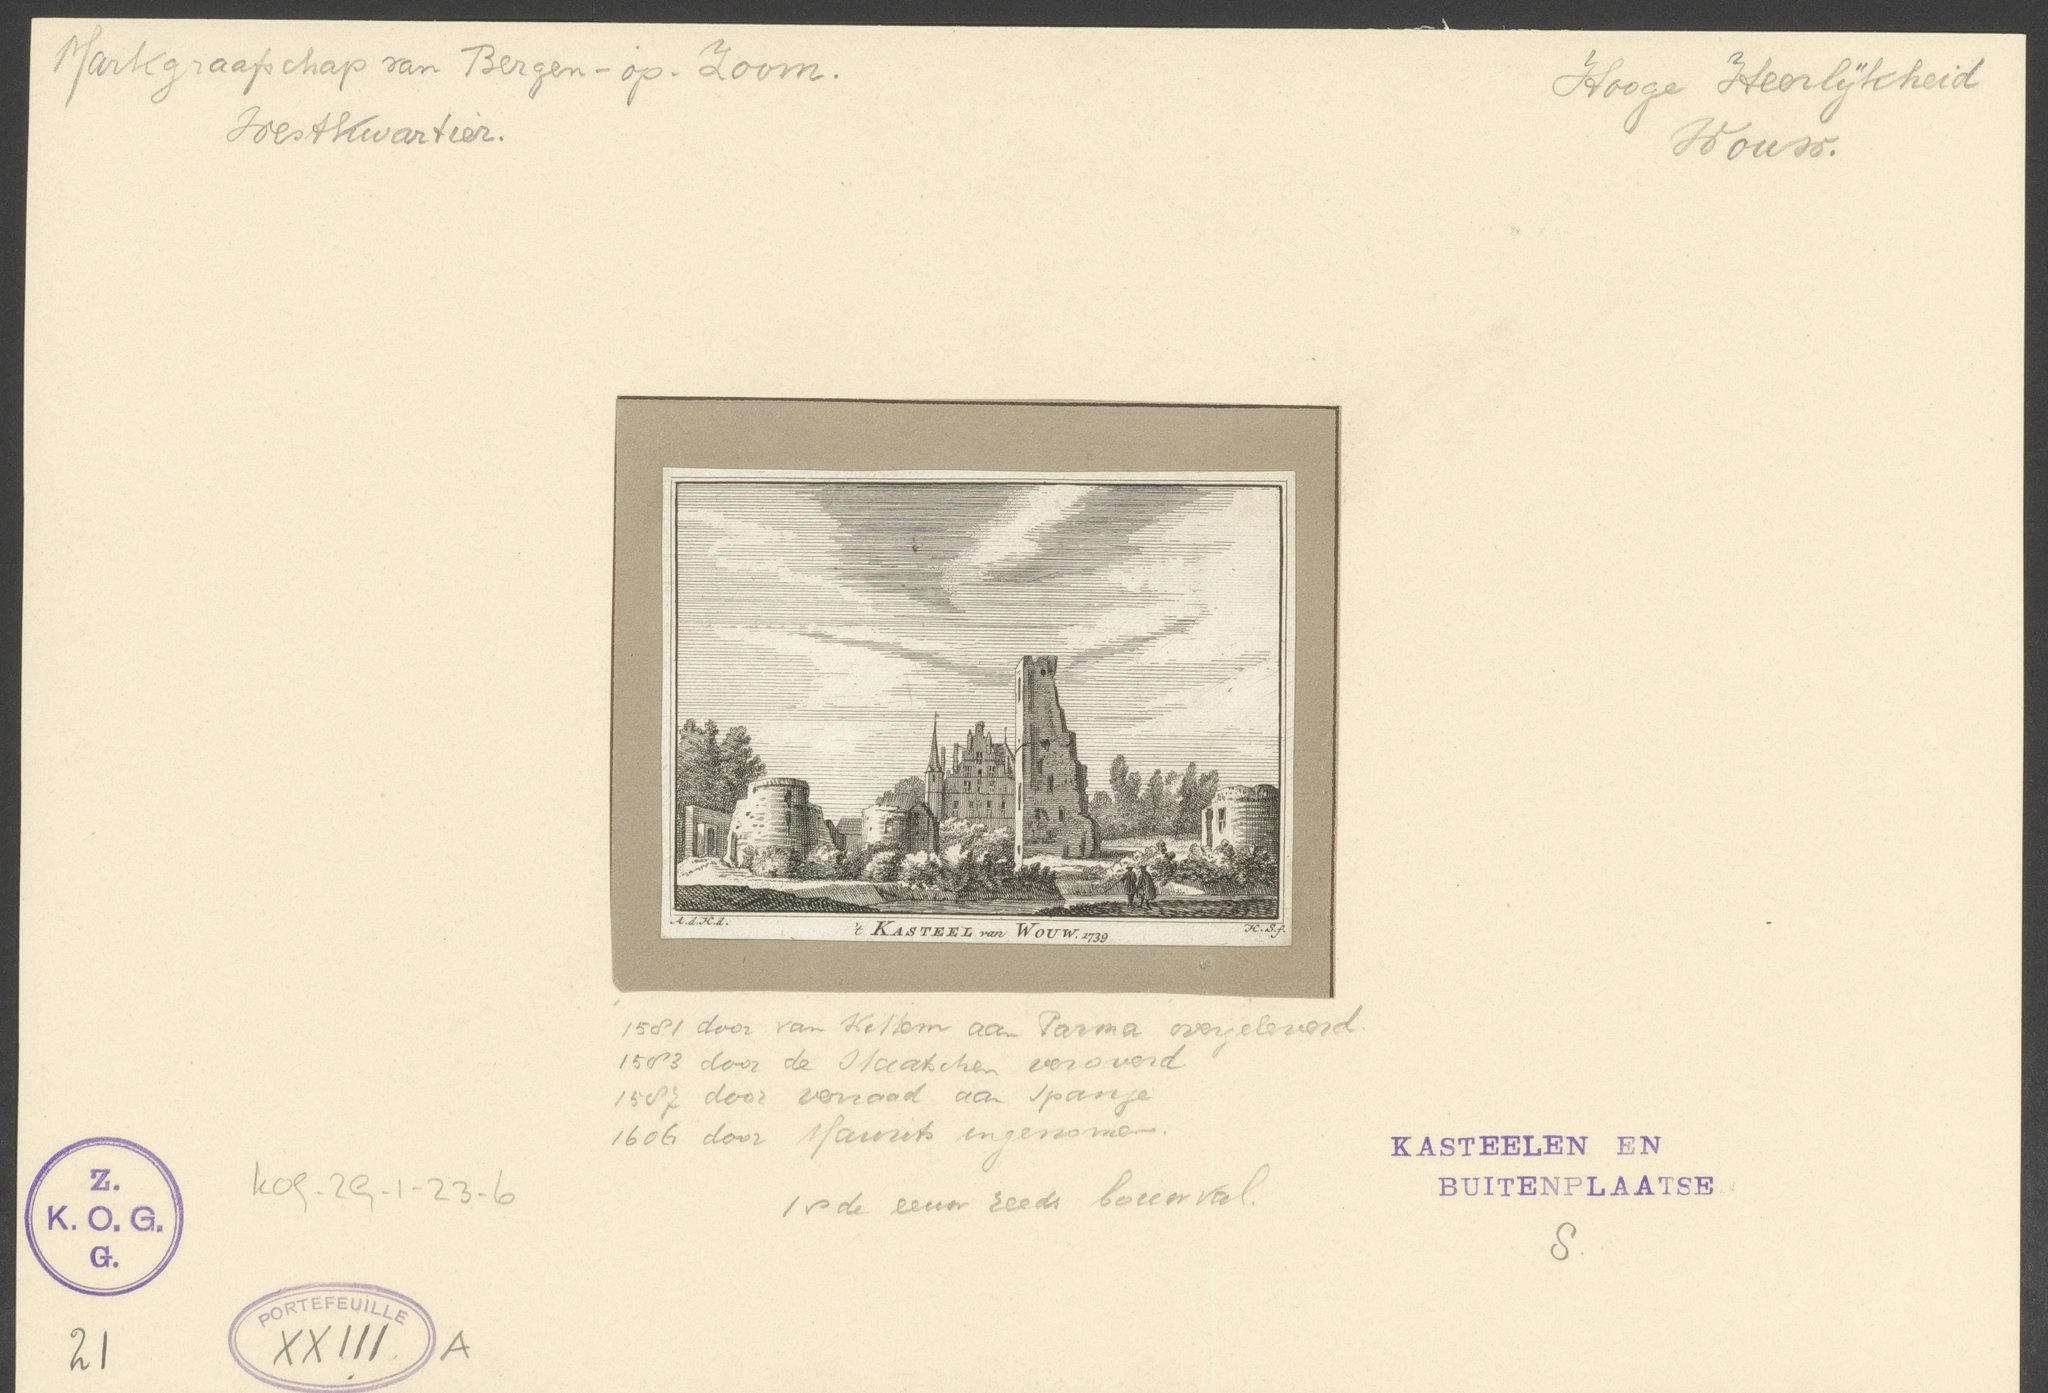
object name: print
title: 't Kasteel van Wouw. 1739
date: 1746-1792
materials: paper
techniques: engraving, etching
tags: castle, ruin of a dwelling, house, castle, etc.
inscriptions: collector's mark: Lugt 1641, stamp, stamp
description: Prent ook gebruikt in: Het verheerlykt Nederland of kabinet van hedendaagsche gezigten van steden, dorpen (…). 9 dln. Amsterdam: Isaak Tirion en weduwe Isaak Tirion, 1745-1774, dl. 2 (1746). Of in: Nederlandsche tafereelen; of eene keurige verzameling van negen honderd fraaije gezigten van steden, dorpen, sloten, oudheden (….). 9 dln. Amsterdam: Jan de Groot, 1792, dl. 2.